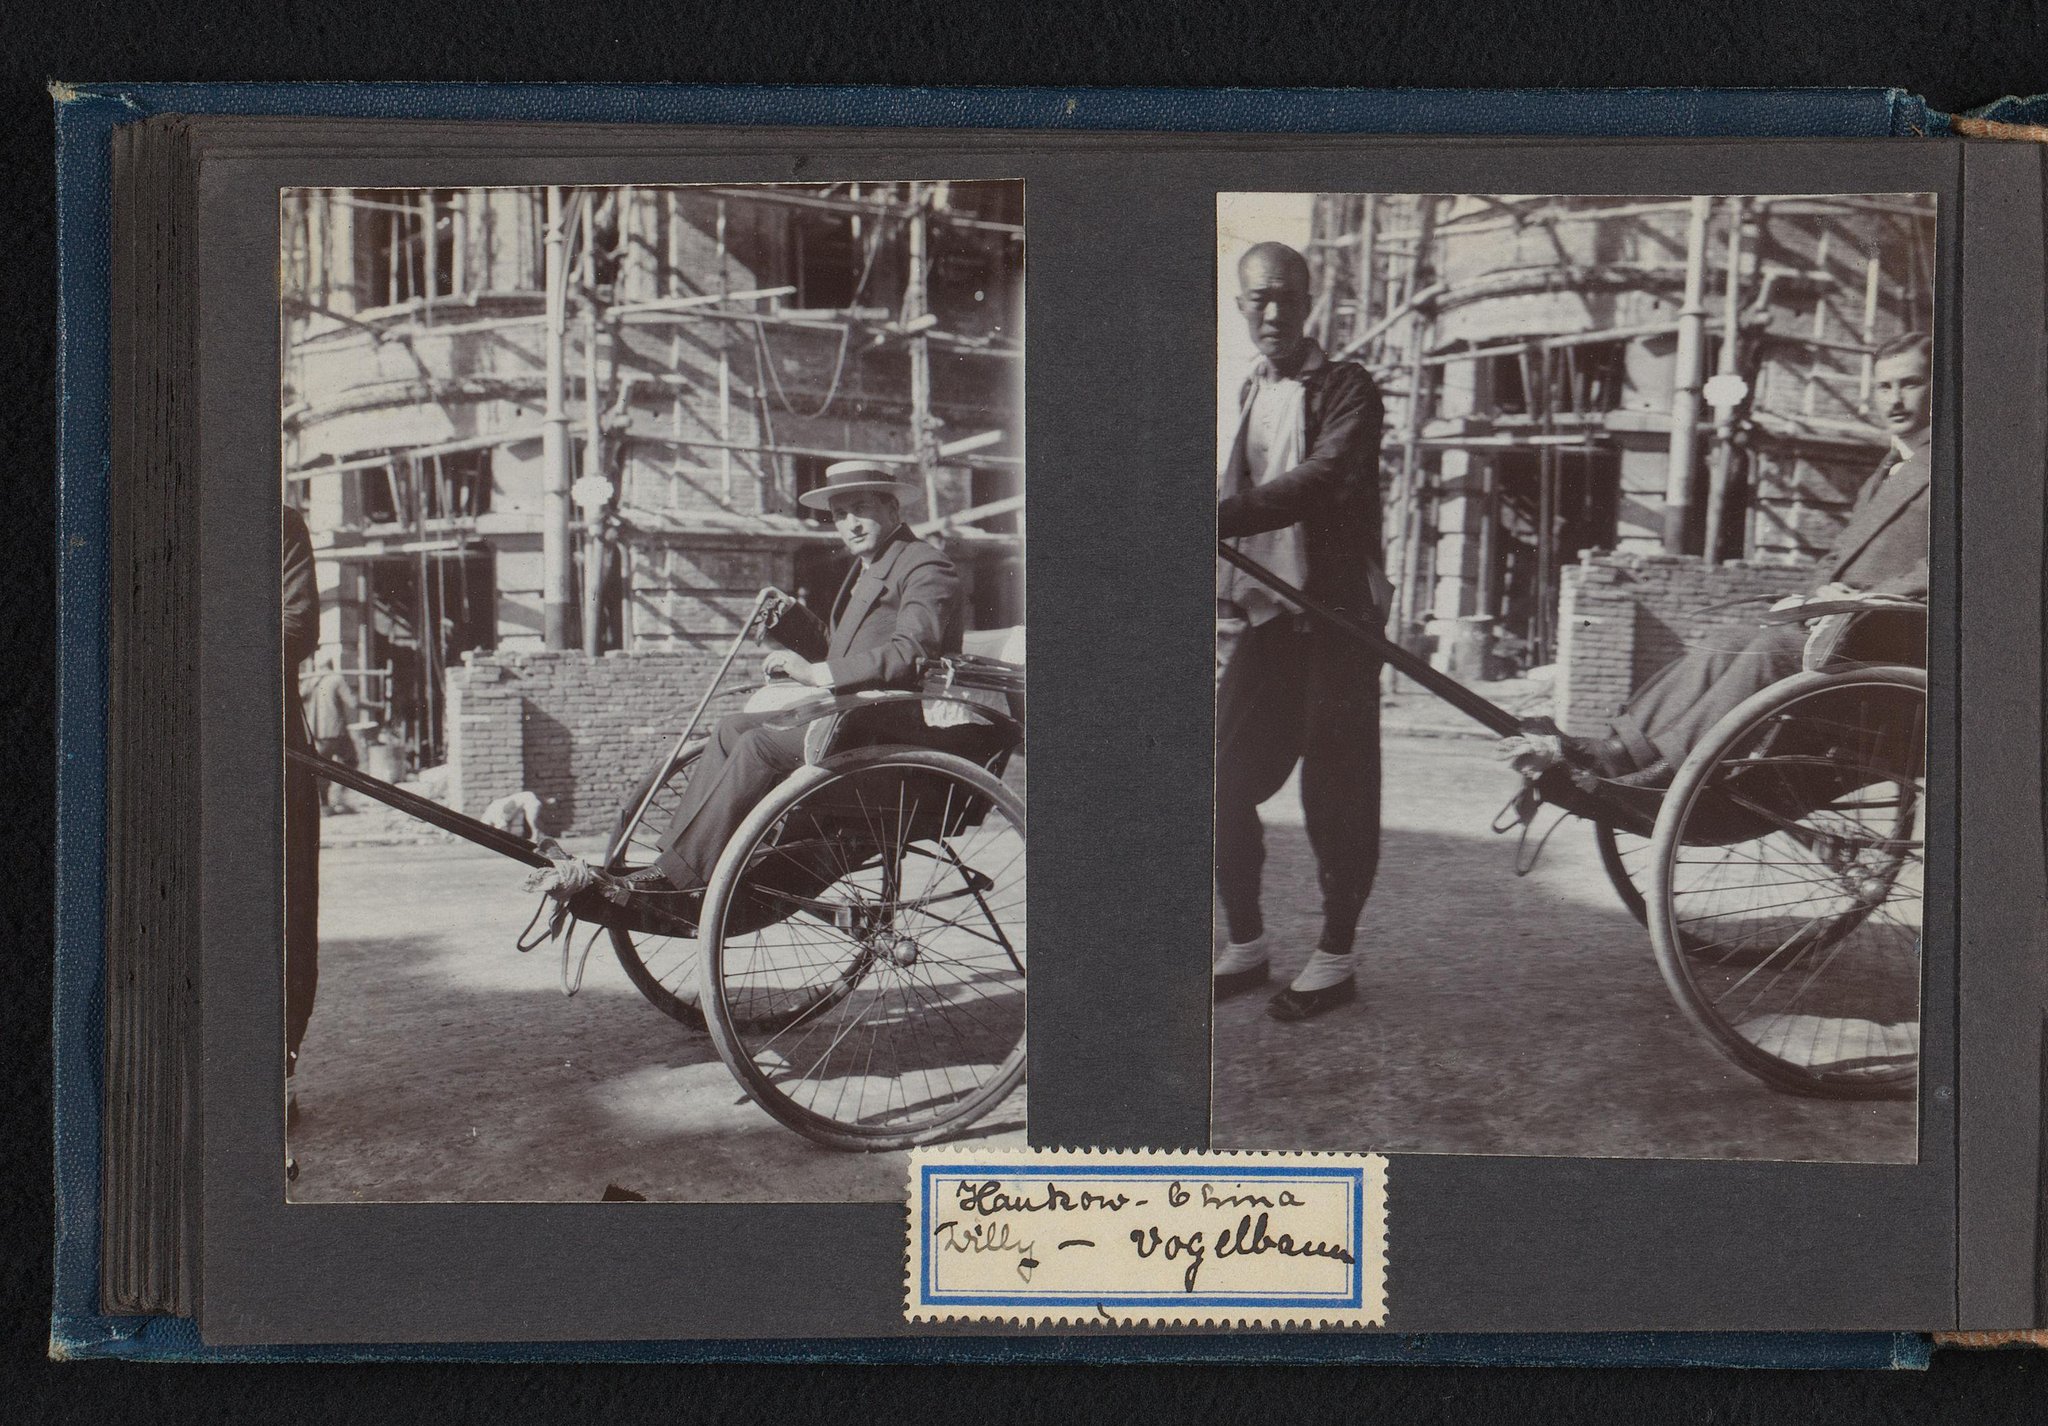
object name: photograph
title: Willy Moos in China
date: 1913-1914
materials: paper, photographic support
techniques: gelatin silver print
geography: china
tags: else wachenheimer-moos, willy moos, rickshaw, historical persons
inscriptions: inscription: ‘Hankow - China / Willy - Vogelbaum’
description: Albumblad met twee foto's van Willy Moos en een andere man in een riksja in Hankou in China. Onderdeel van het fotoalbum van Else Wachenheimer-Moos en haar broers Arthur en Willy Moos en anderen in de periode 1913-1918.